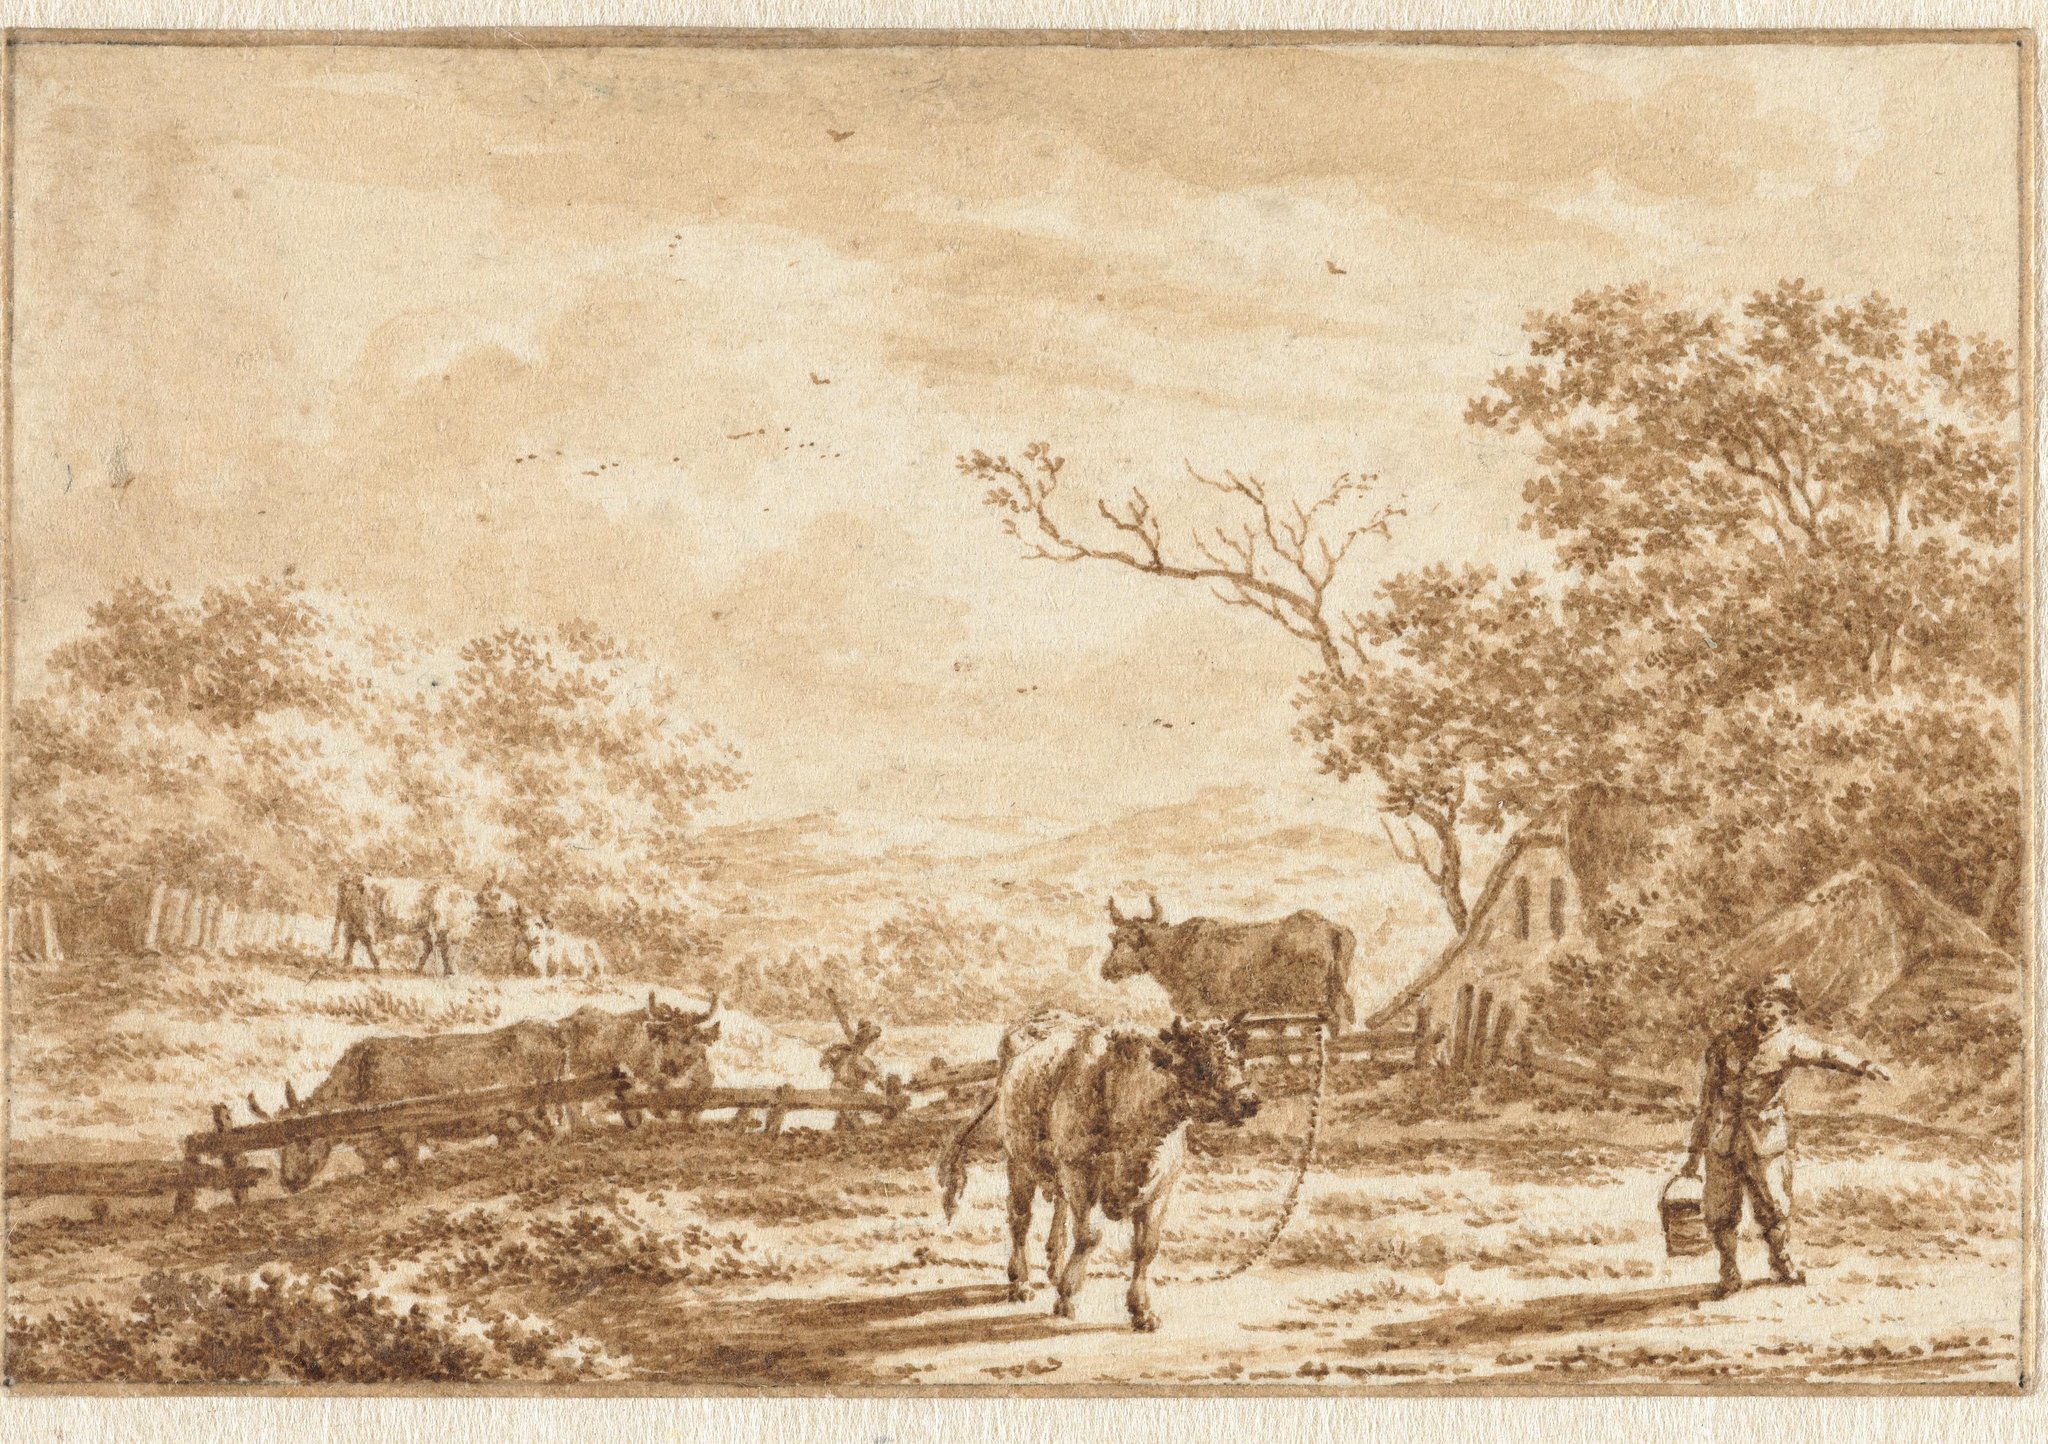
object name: drawing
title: Landschap met vee en boer met emmer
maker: jacob cats (1741-1799)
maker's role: draughtsman, print maker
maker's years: 1741-1799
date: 1778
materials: ink, paper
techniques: brush, pen